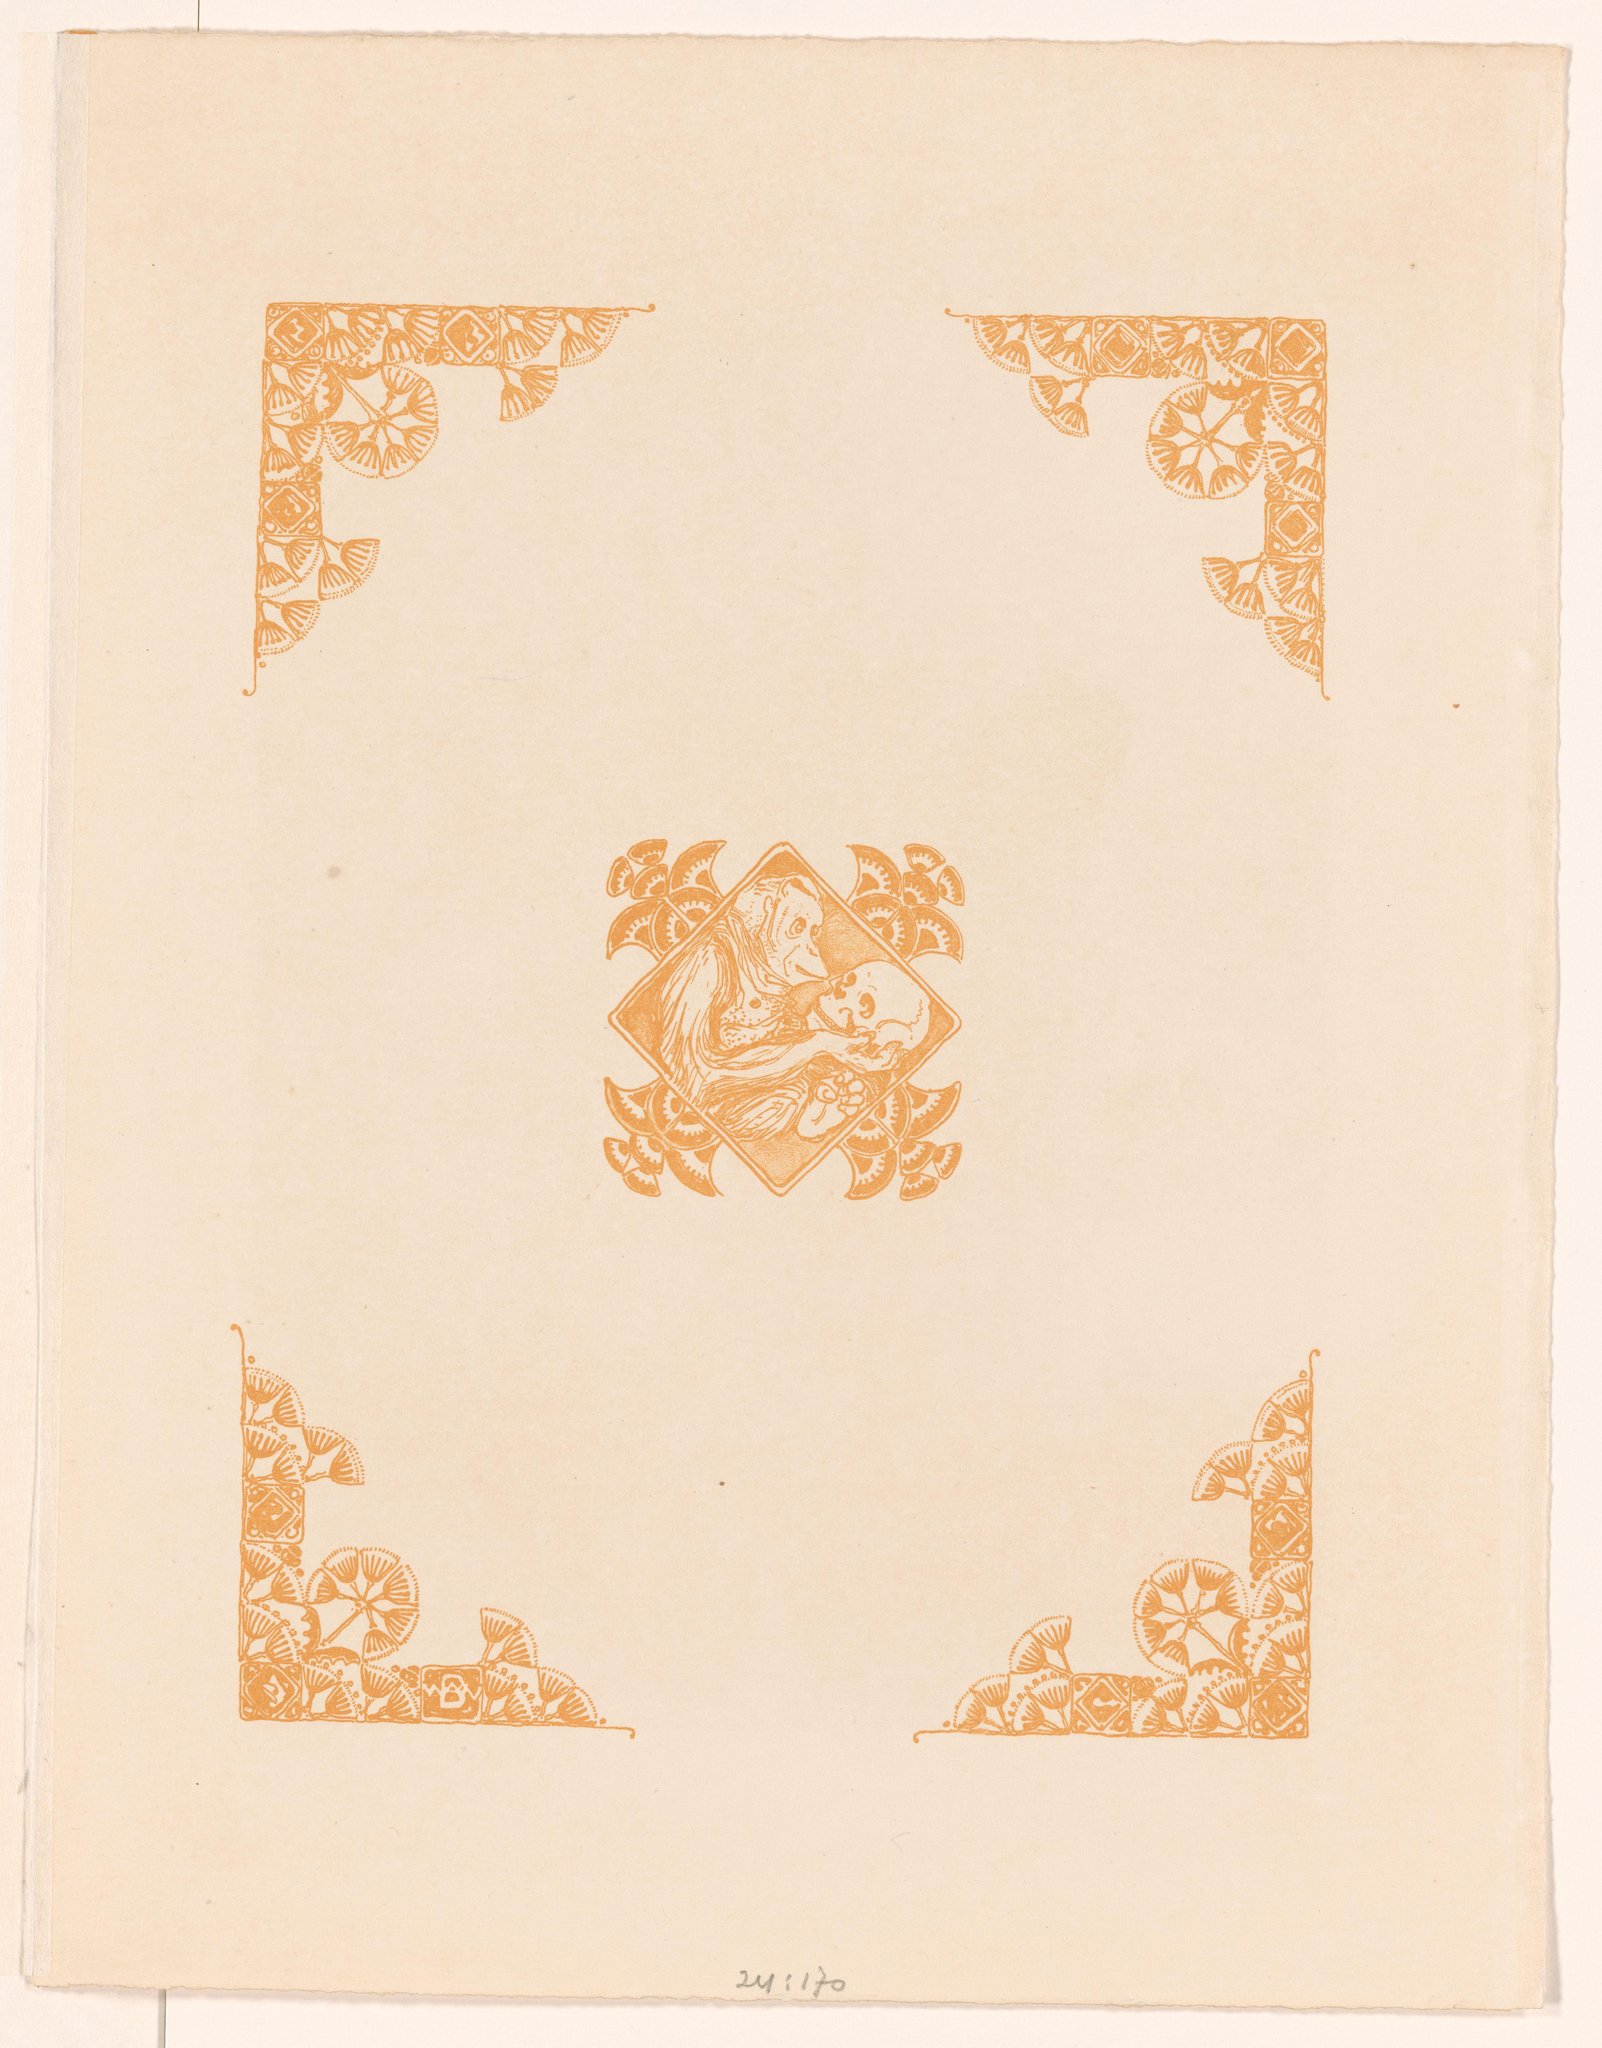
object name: print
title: Ornamentiek en een aap met een schedel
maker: bernard willem wierink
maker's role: draughtsman, print maker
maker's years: 1856-1939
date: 1910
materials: paper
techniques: lithograph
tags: fable of reynard the fox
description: Prent gebruikt in: Streuvels, Stijn (Frank Lateur). Reinaert de Vos naar verschillende uitgaven van het middeleeuwsche epos. Amsterdam: L.J. Veen, 1910.